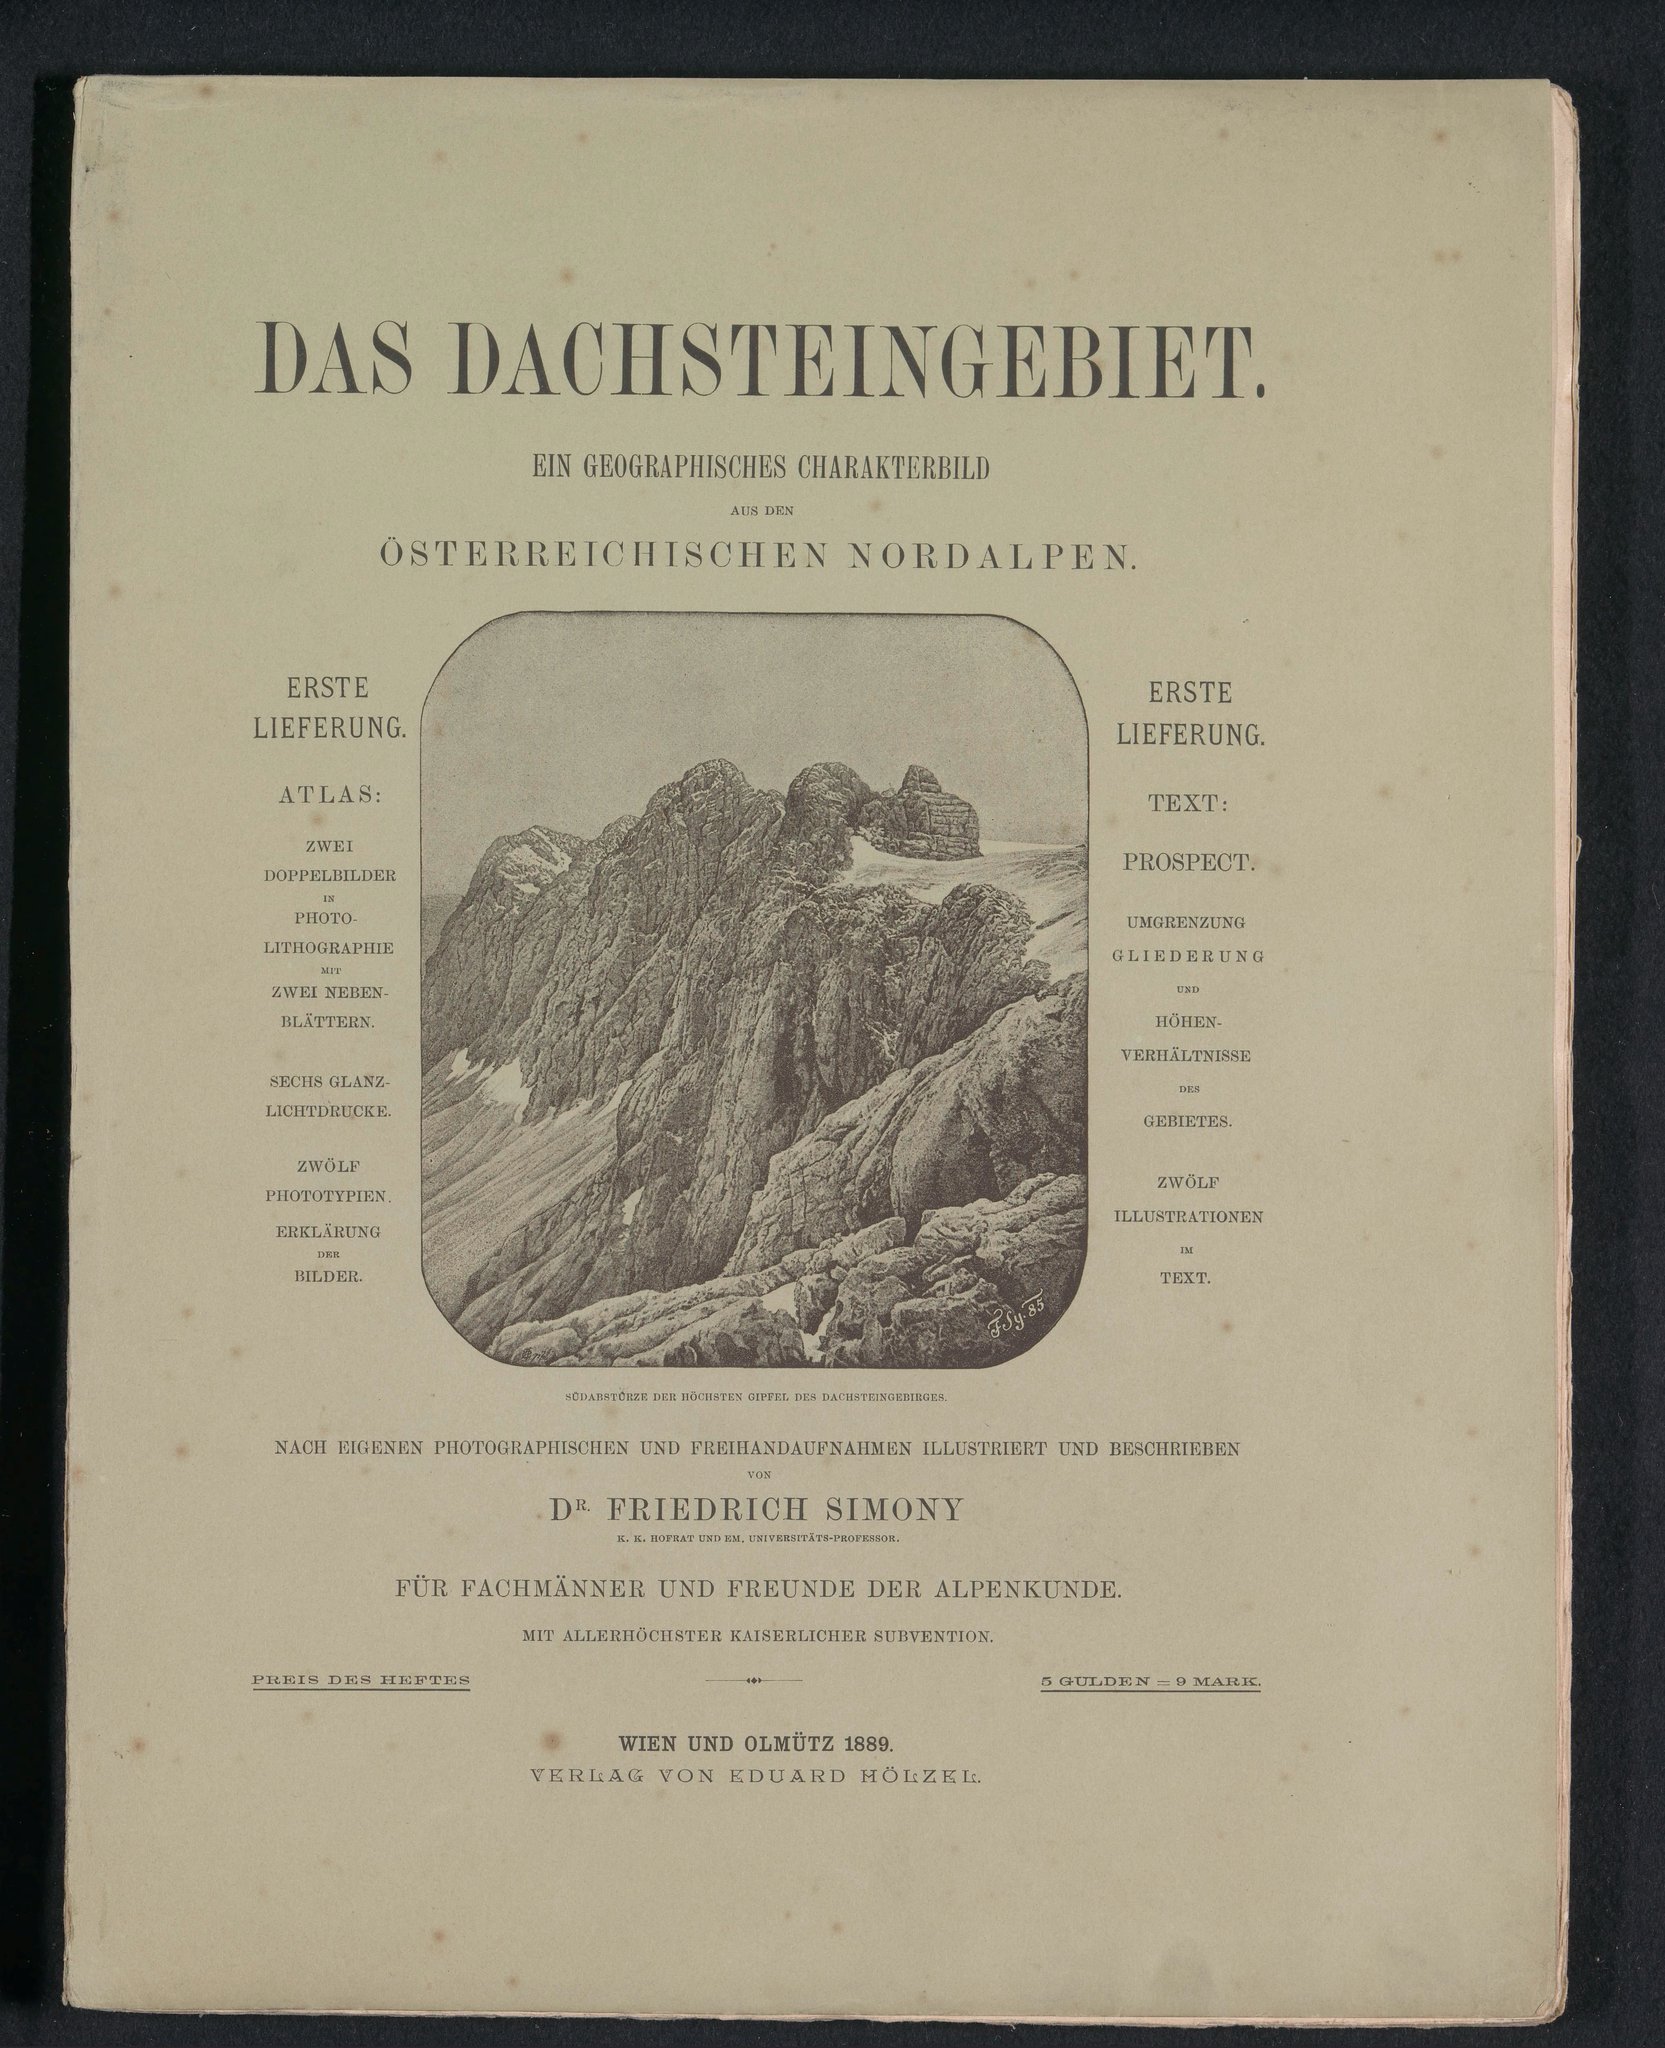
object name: photomechanical print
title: Südabstürze der höchsten Gipfel den Dachsteingebirgen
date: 1885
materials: paper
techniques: autotype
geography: bas-rhin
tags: mountain-top, peak